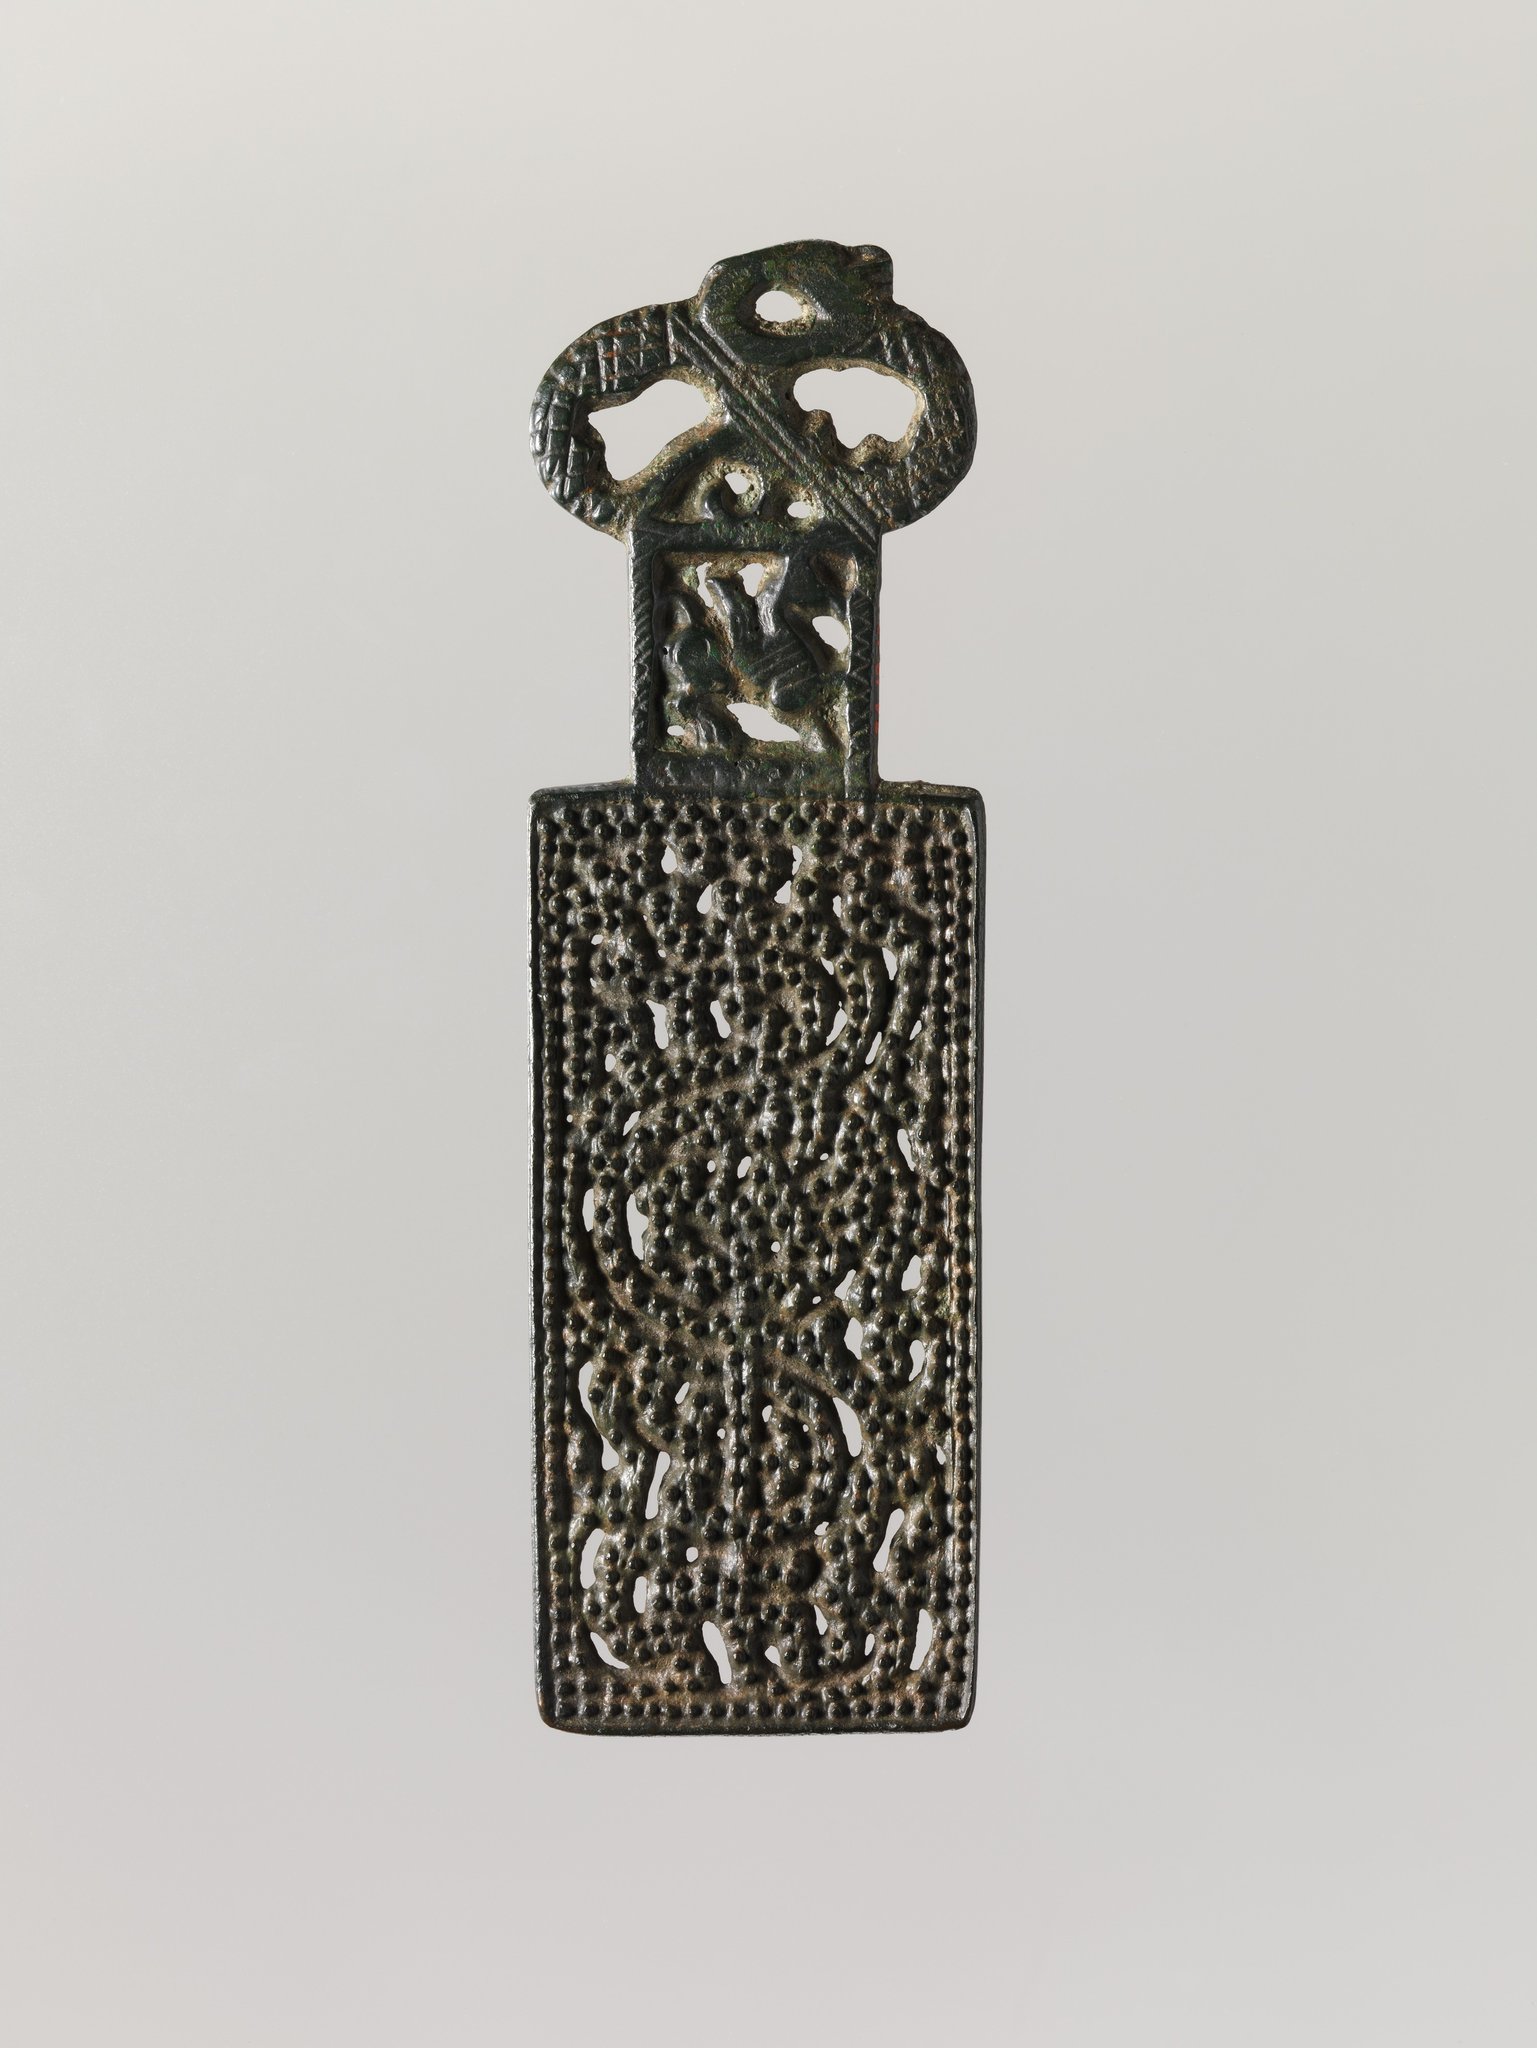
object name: knife coin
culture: chinese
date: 206 BCE-220 CE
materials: bronze